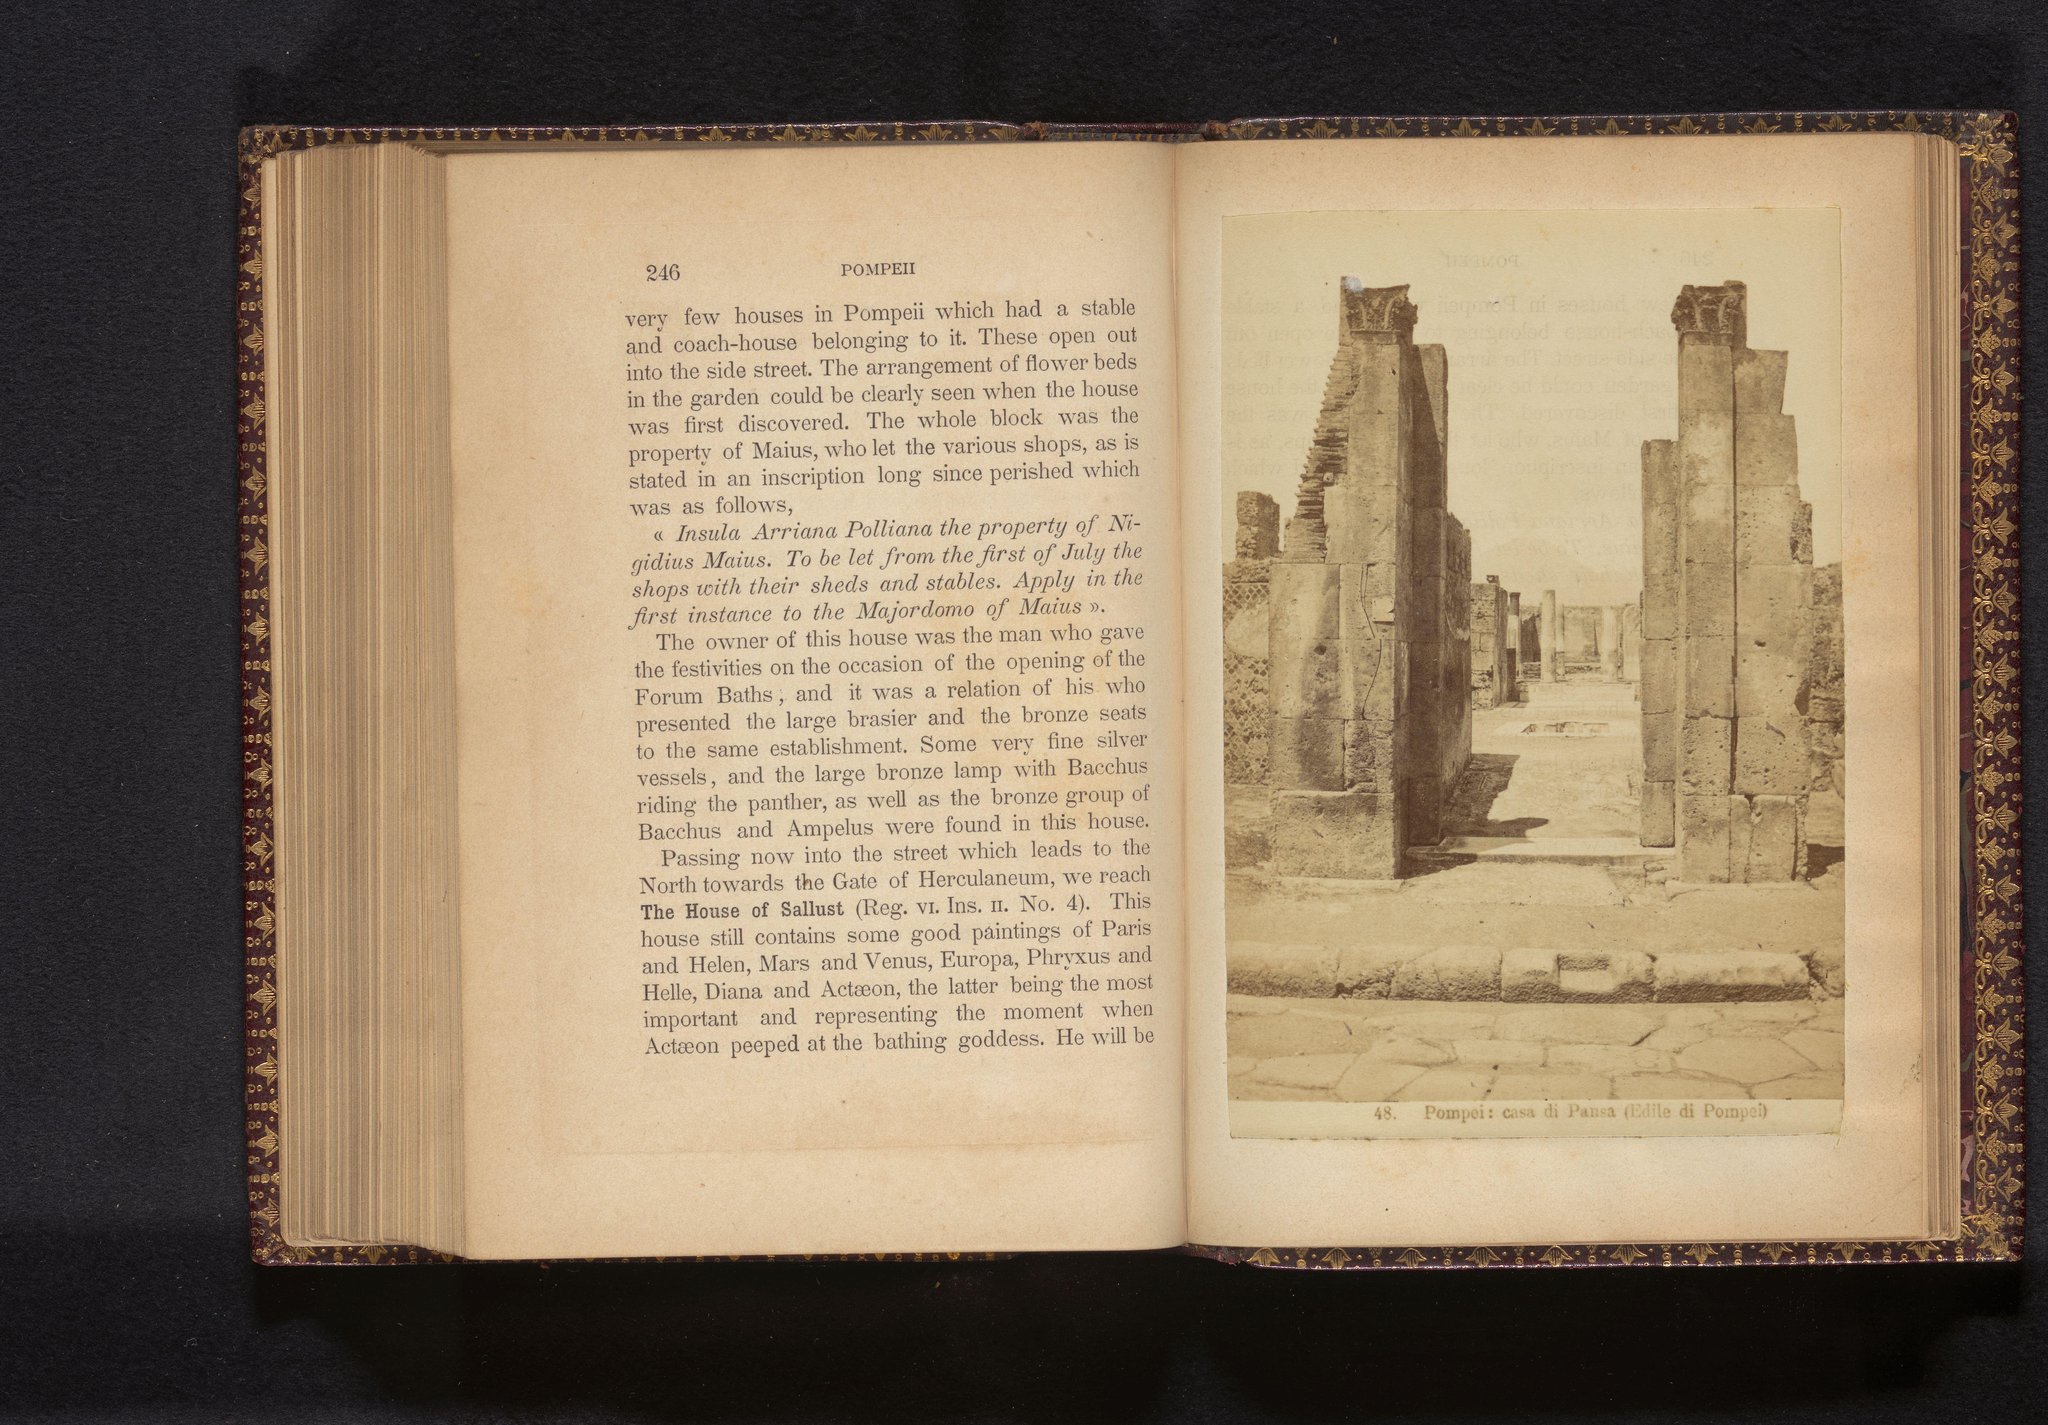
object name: photograph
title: Pompei: casa di Pansa (Edile di Pompei)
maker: Anonymous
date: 1878-1888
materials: photographic support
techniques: albumen print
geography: pompeii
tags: ruin of a building ~ architecture, housing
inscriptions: number: ‘48.’